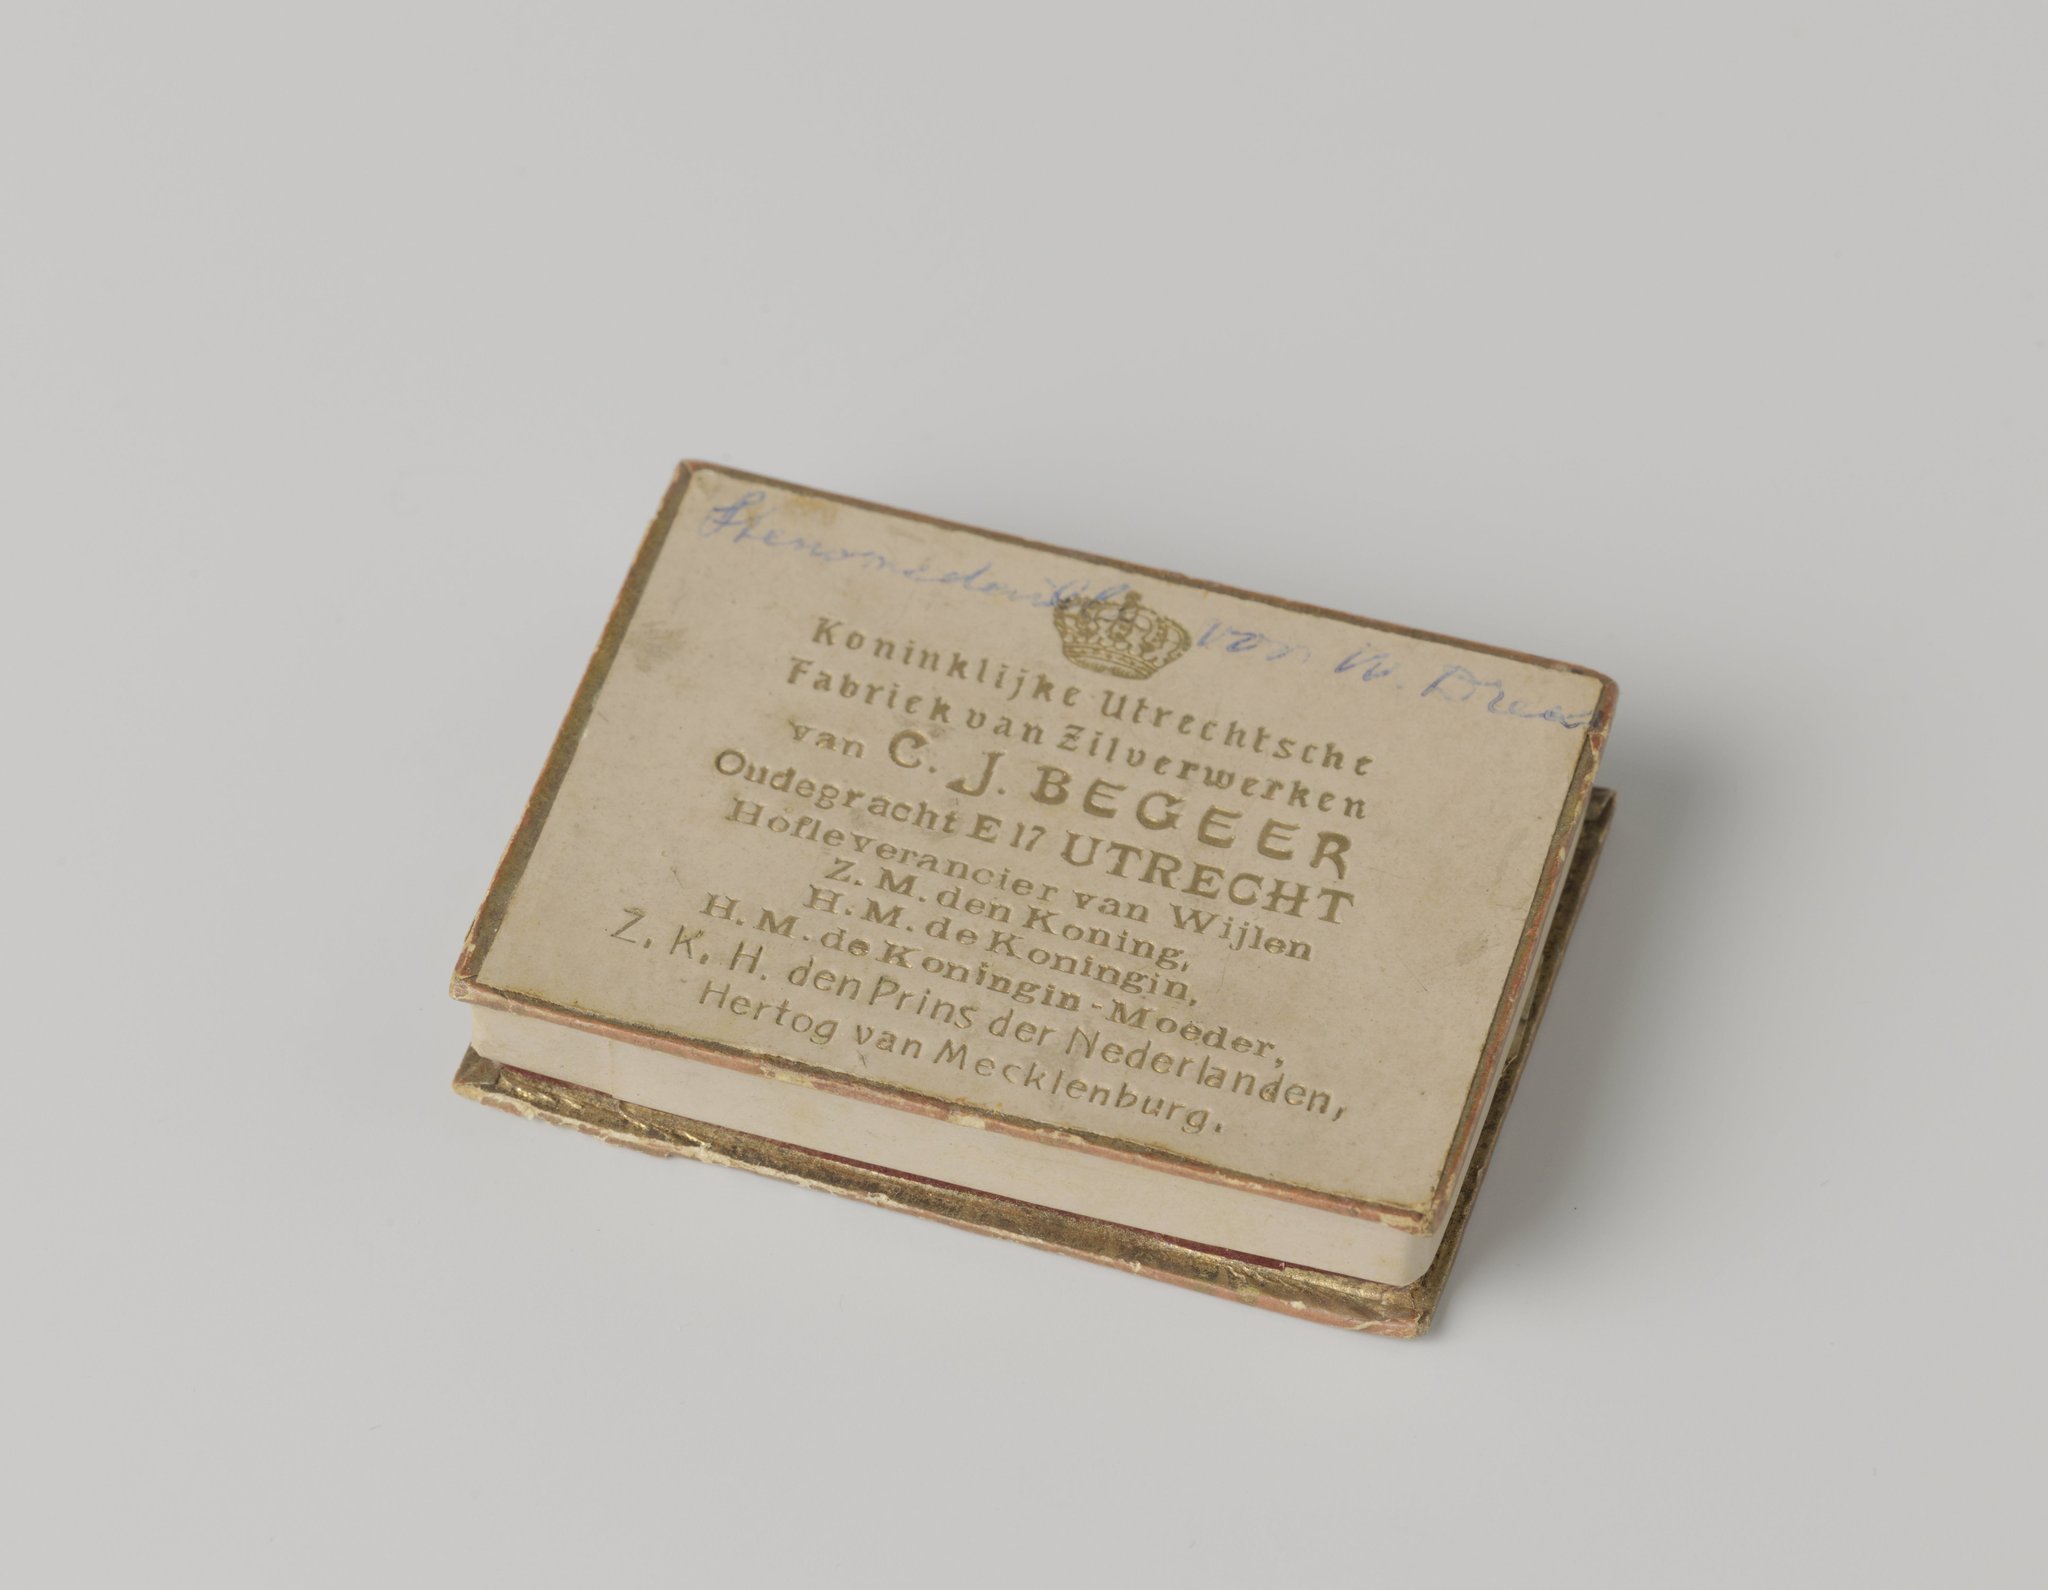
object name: box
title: Doosje bij prijspenning Openbare proef stenografie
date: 1903-1908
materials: cardboard, textile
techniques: pasting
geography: utrecht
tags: amsterdam, the hague, willem drees, netherlands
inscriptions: inscription: ‘Stenomedaille voor W. Drees’, inscription: ‘Koninklijke Utrechtsche Fabriek van Zilverwerken van C.J. BEGEER Oudegracht E17 UTRECHT Hofleverancier van Wijlen Z.M. den Koning, H.M. de Koningin, H.M. de Koningin-Moeder, Z.K.H. den Prins der Nederlanden, Hertog van Mecklenburg.’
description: Rechthoekig kartonnen wit doosje met bruine randen. Op los deksel opschrift ingedrukt en beschreven. Binnenzijde rood fluweel.